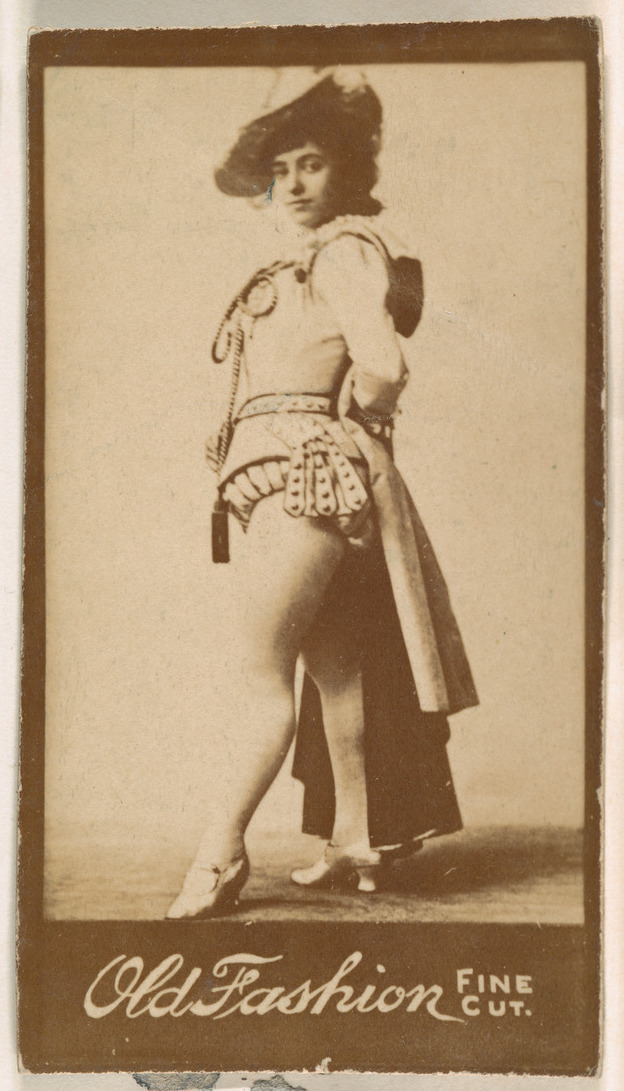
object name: photograph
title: Actress standing with hands behind waist, from the Actresses series (N664) promoting Old Fashion Fine Cut Tobacco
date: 1888-1890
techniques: albumen silver print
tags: portraits,women,actresses